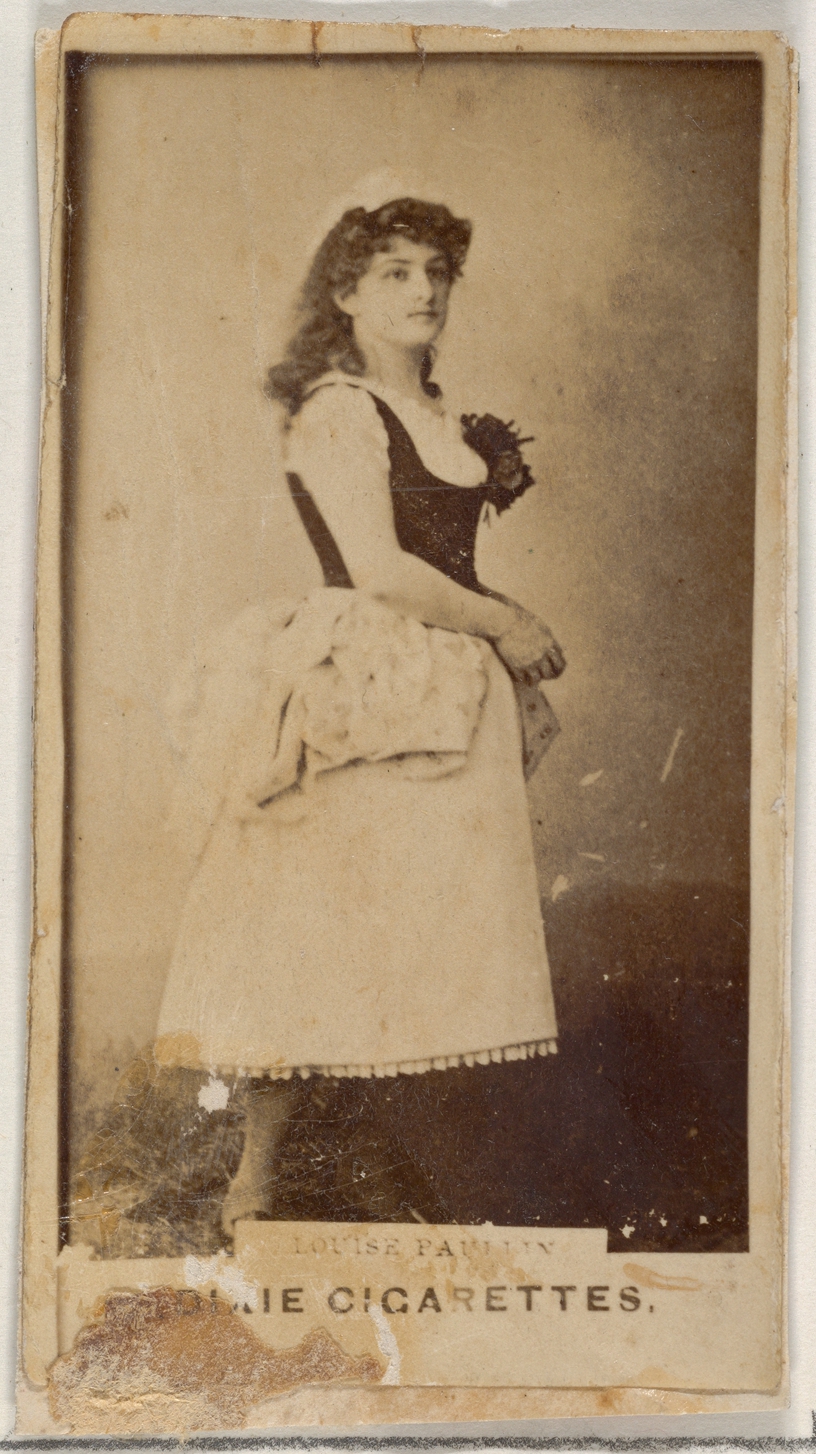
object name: photograph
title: Louise Paullin, from the Actors and Actresses series (N45, Type 7) for Dixie Cigarettes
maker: allen & ginter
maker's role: publisher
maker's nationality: american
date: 1888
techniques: albumen silver print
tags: portraits,women,actresses